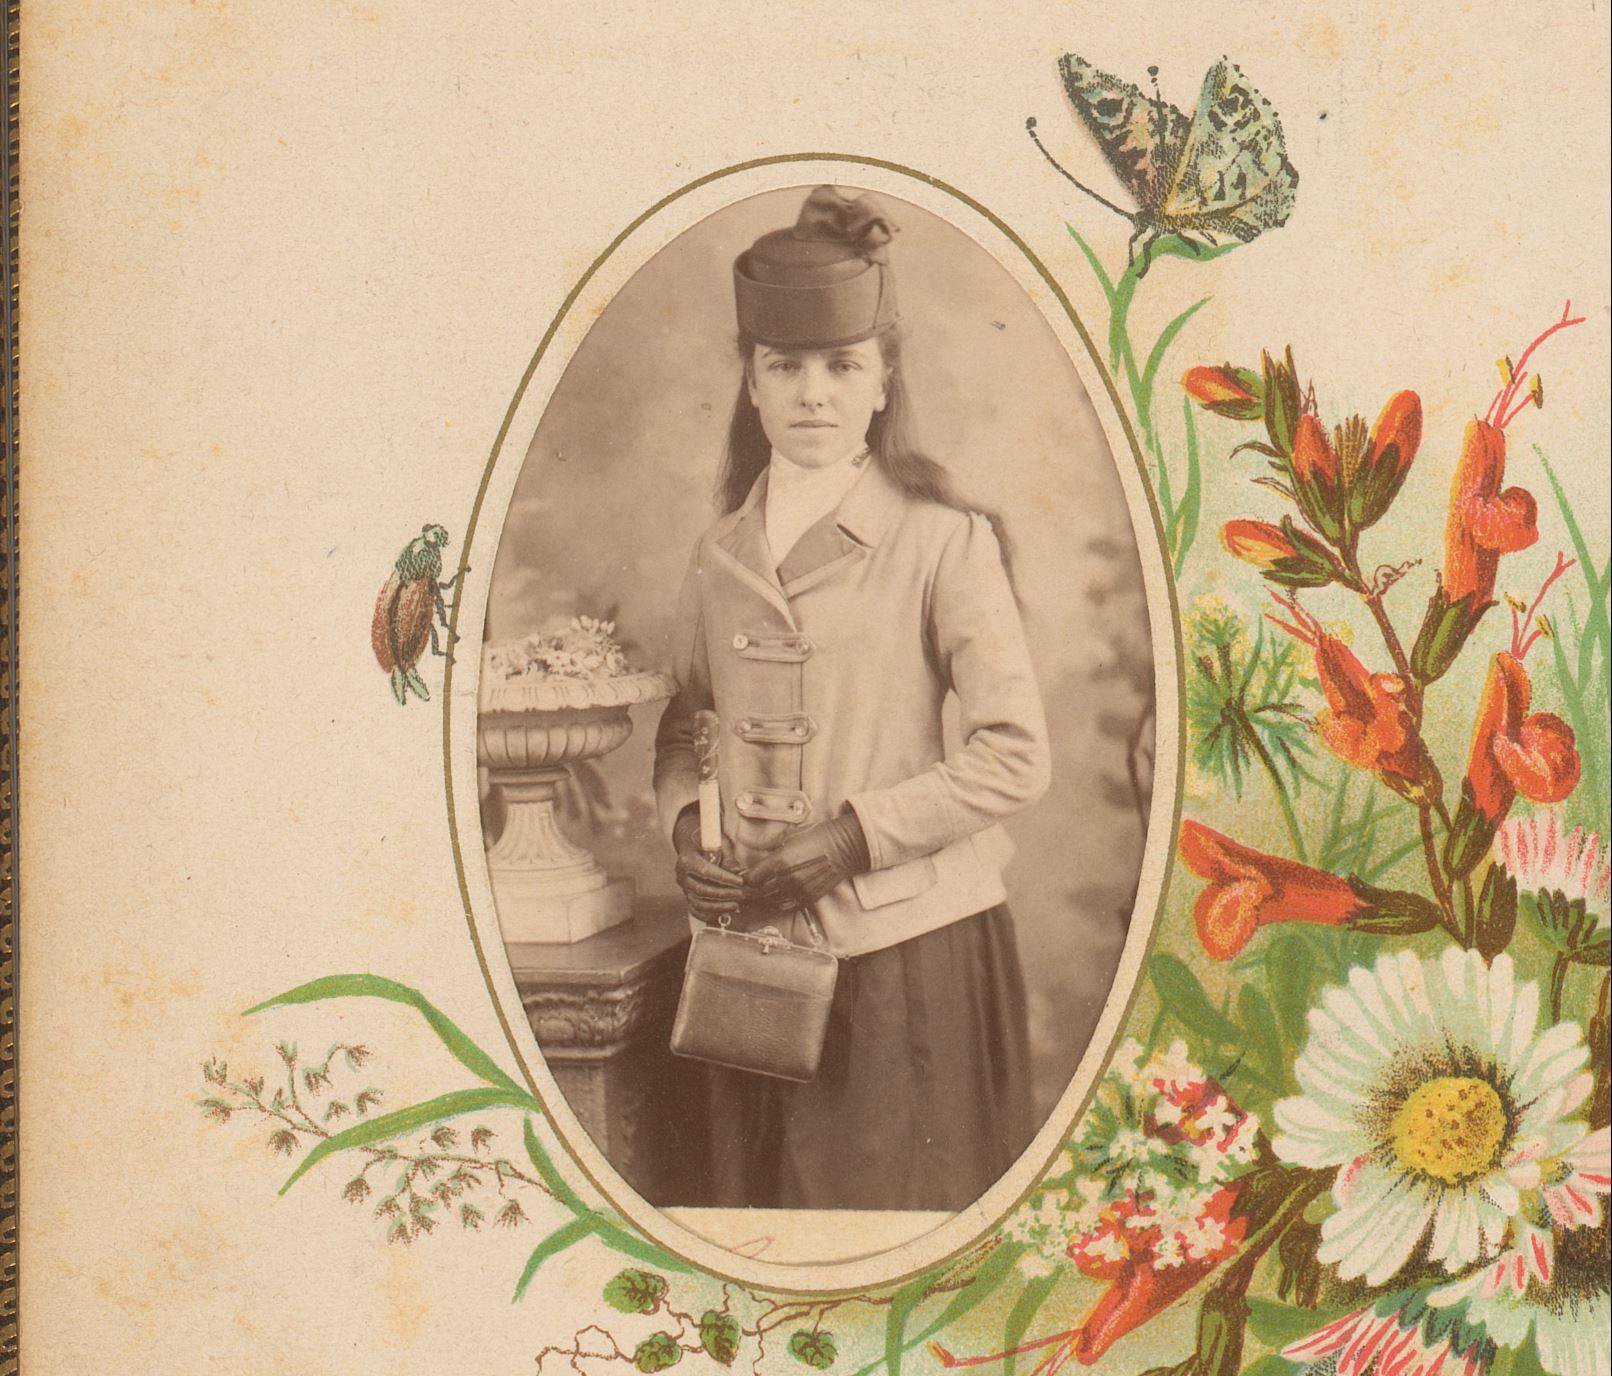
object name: album leaf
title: Portret van een jonge vrouw met hoed en handtas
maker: w.t. wilkinson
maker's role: fotograaf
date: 1860-1900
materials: cardboard, photographic support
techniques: albumen print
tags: adolescent, young woman, maiden, purse, money-bag, historical persons, head-gear: hat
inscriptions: inscription: ‘Wilkinson/ inventor/ and sole proprietor/ of the new/ Photo mechanical process/ (...)’